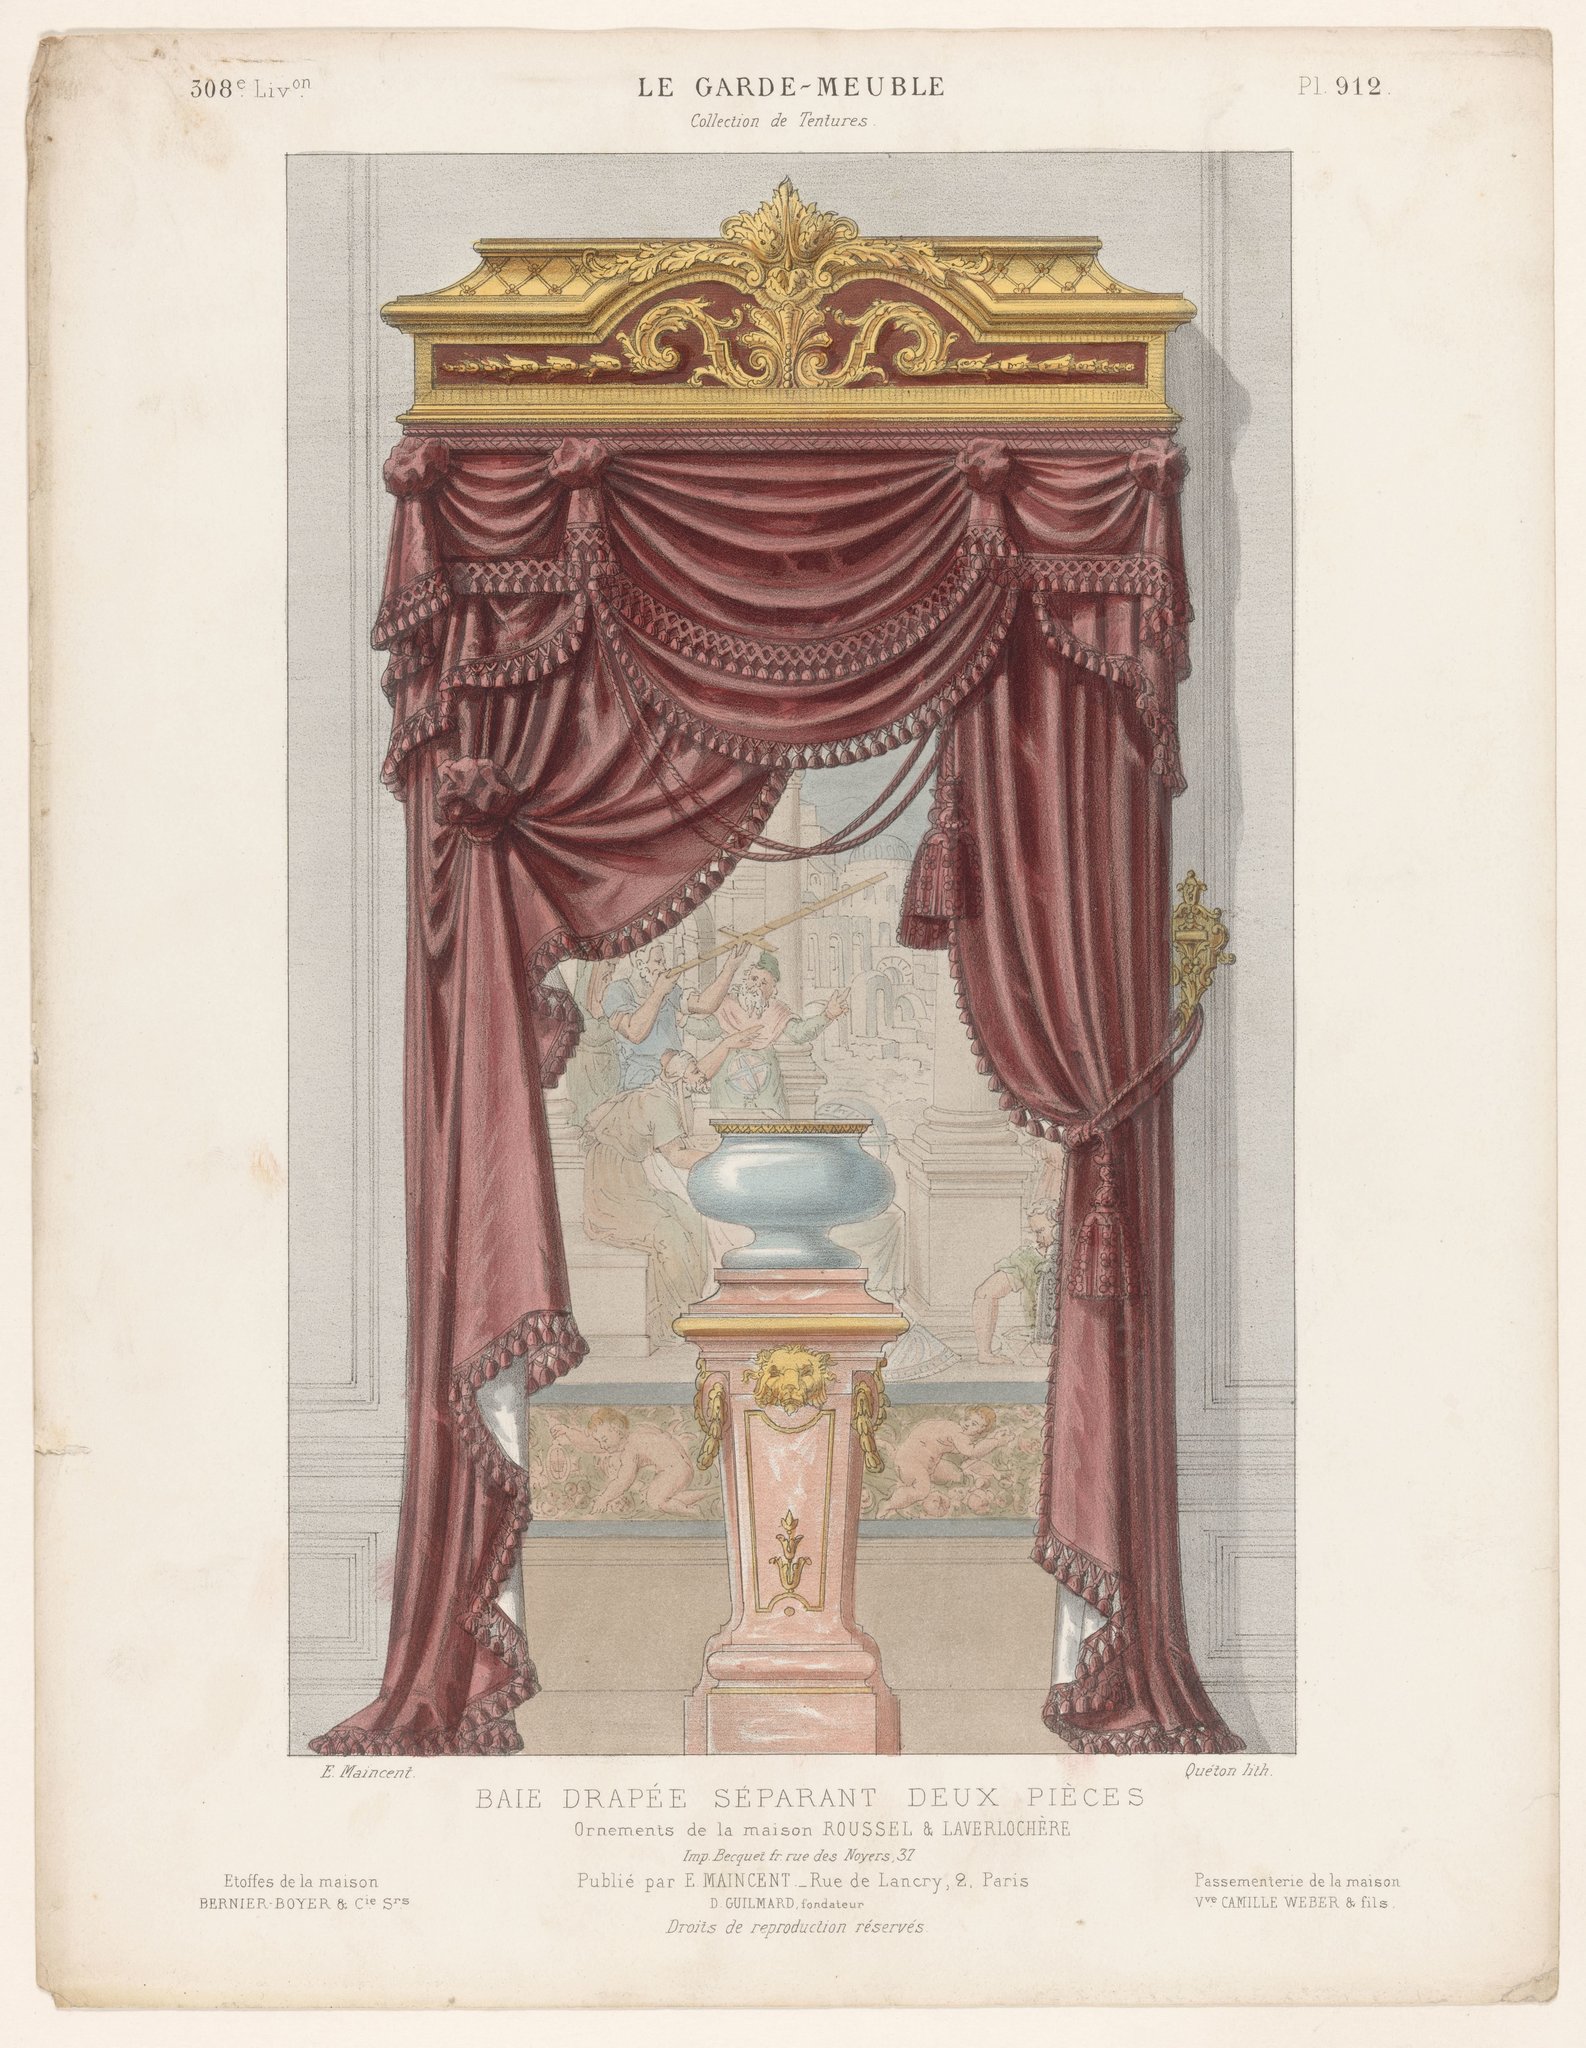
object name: print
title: Baie drapée séparant deux Pièces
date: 1885-1895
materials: paper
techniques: hand coloring, lithograph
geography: paris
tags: decorations (interior of the house), open door, hangings and drapery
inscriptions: : ‘Droits de reproduction réservés.’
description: Doorgang met gedrapeerde gordijnen tussen twee vertrekken. Prent uit 308e Livraison.